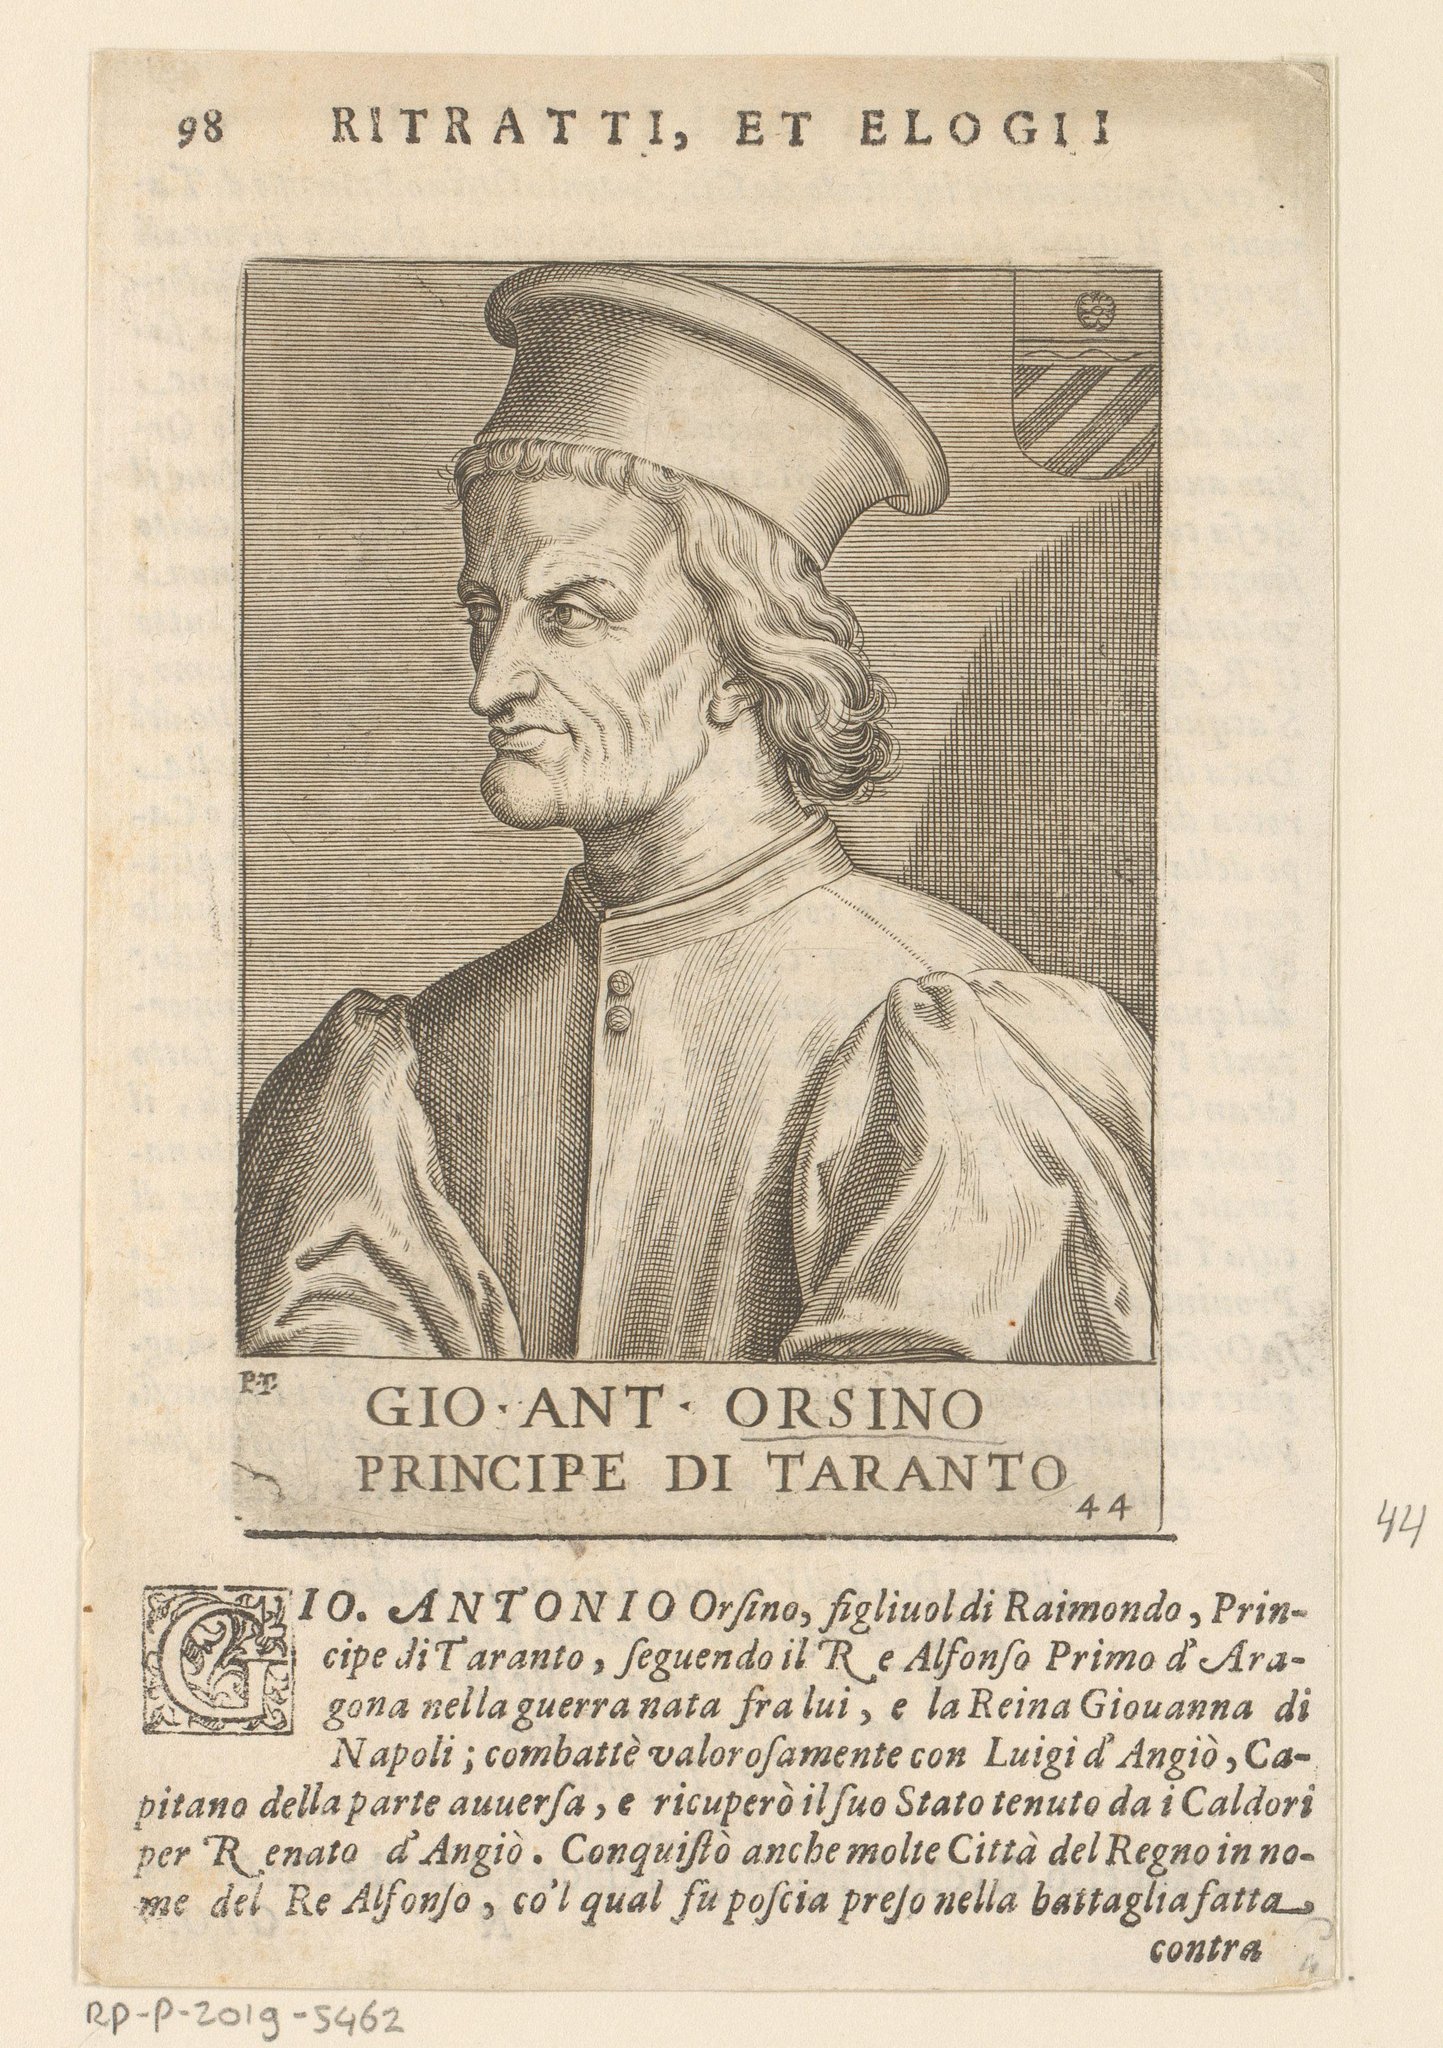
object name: book illustration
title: Gio. Ant. Orsino principe di Taranto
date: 1635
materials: paper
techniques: engraving, letterpress printing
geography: rome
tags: lecce, commander-in-chief, general, marshal, historical persons, armorial bearing, heraldry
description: Prent uit: Ritratti et elogii di capitani Illustri. Rome: Pompilio Totti en Andrea Fei, 1635, p. 98. Eerdere staat van prent in ieder geval ook gebruikt in: Ritratti di cento capitani illustri con li lor Fatti in guerra (…), Rome: Domenico Gigliotti, 1596. Latere staat van prent in ieder geval ook gebruikt in: Ritratti et elogii di capitani Illustri. Che ne'secoli moderni hanno gloriosamente guerreggiato. Rome: Filippo de'Rossi en Vitale Mascardi, 1646.